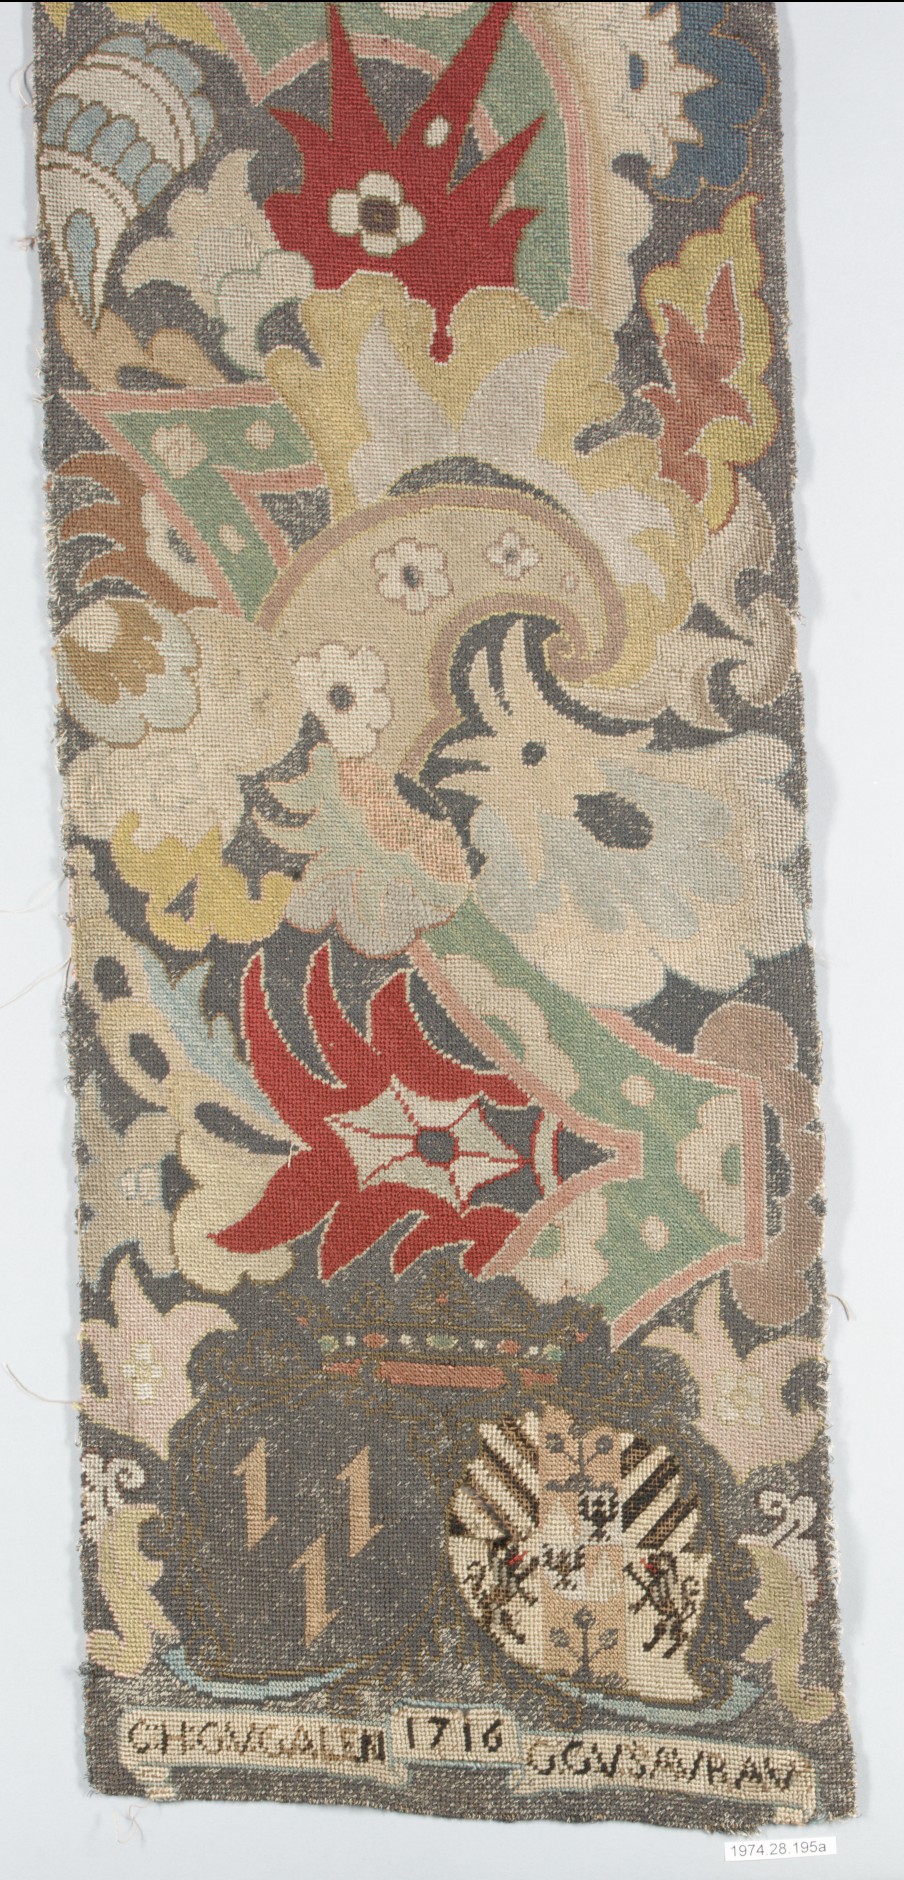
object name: panel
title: Vertical panels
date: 1716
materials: linen, metal thread, silk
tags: coat of arms